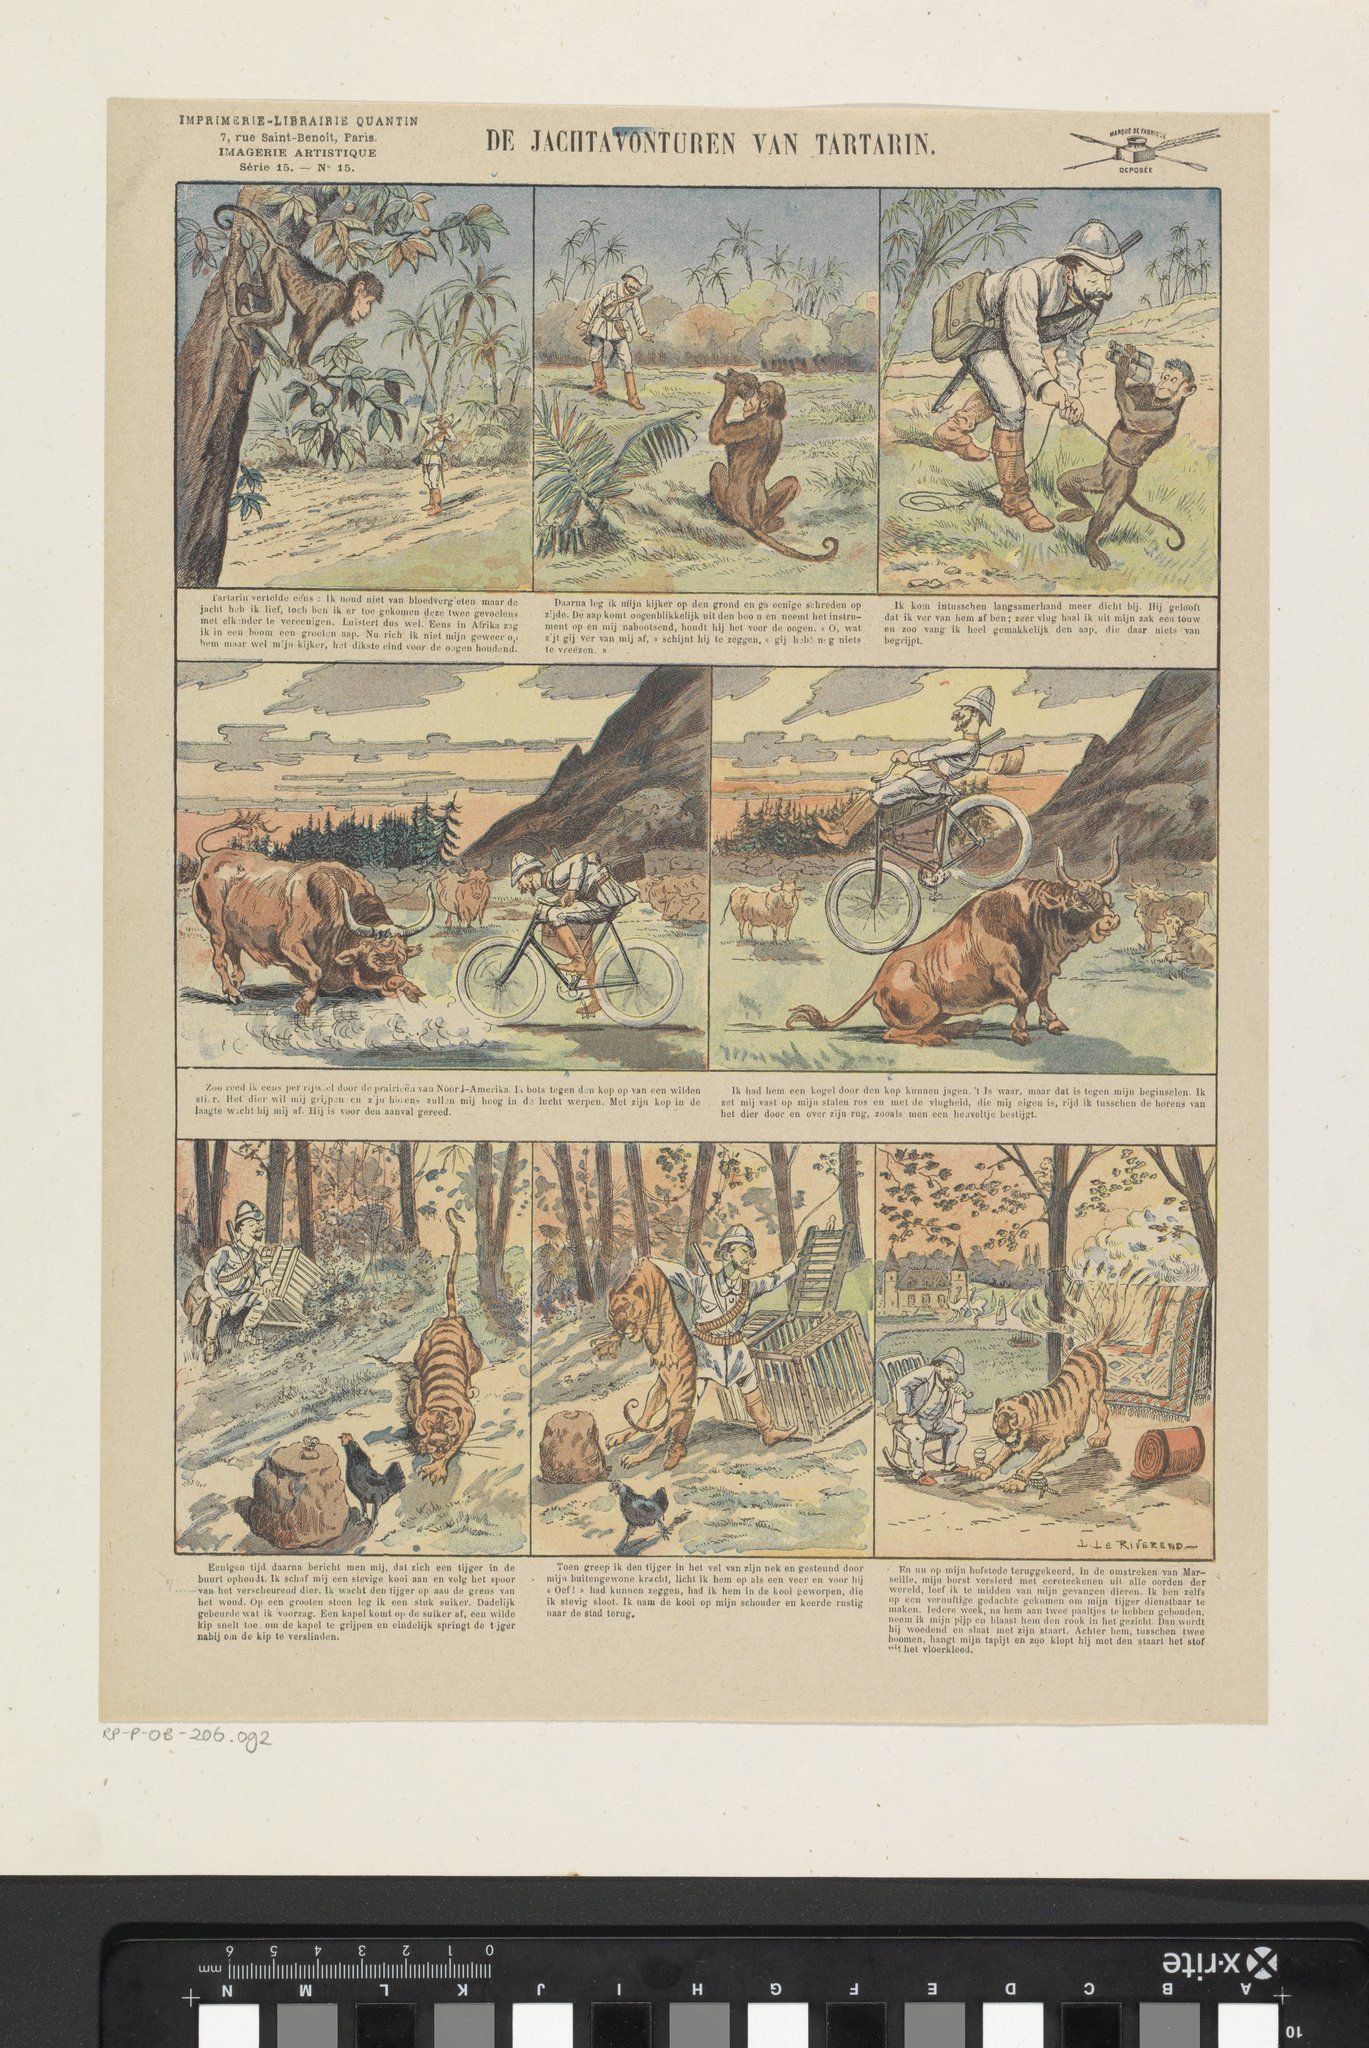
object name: popular print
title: Imagerie Artistique / Série 15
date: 1876-1890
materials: paper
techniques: lithograph, letterpress printing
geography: paris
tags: beasts of prey, predatory animals: tiger, bull, monkeys, apes, hunter, tales and fairy tales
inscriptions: collector's mark: Lugt 2760, : ‘marque de fabrique / deposée’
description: Blad met 8 voorstellingen van de sterke jachtverhalen van Tartarin. Onder elke afbeelding een onderschrift. Genummerd linksboven: Série 15. - No. 15.